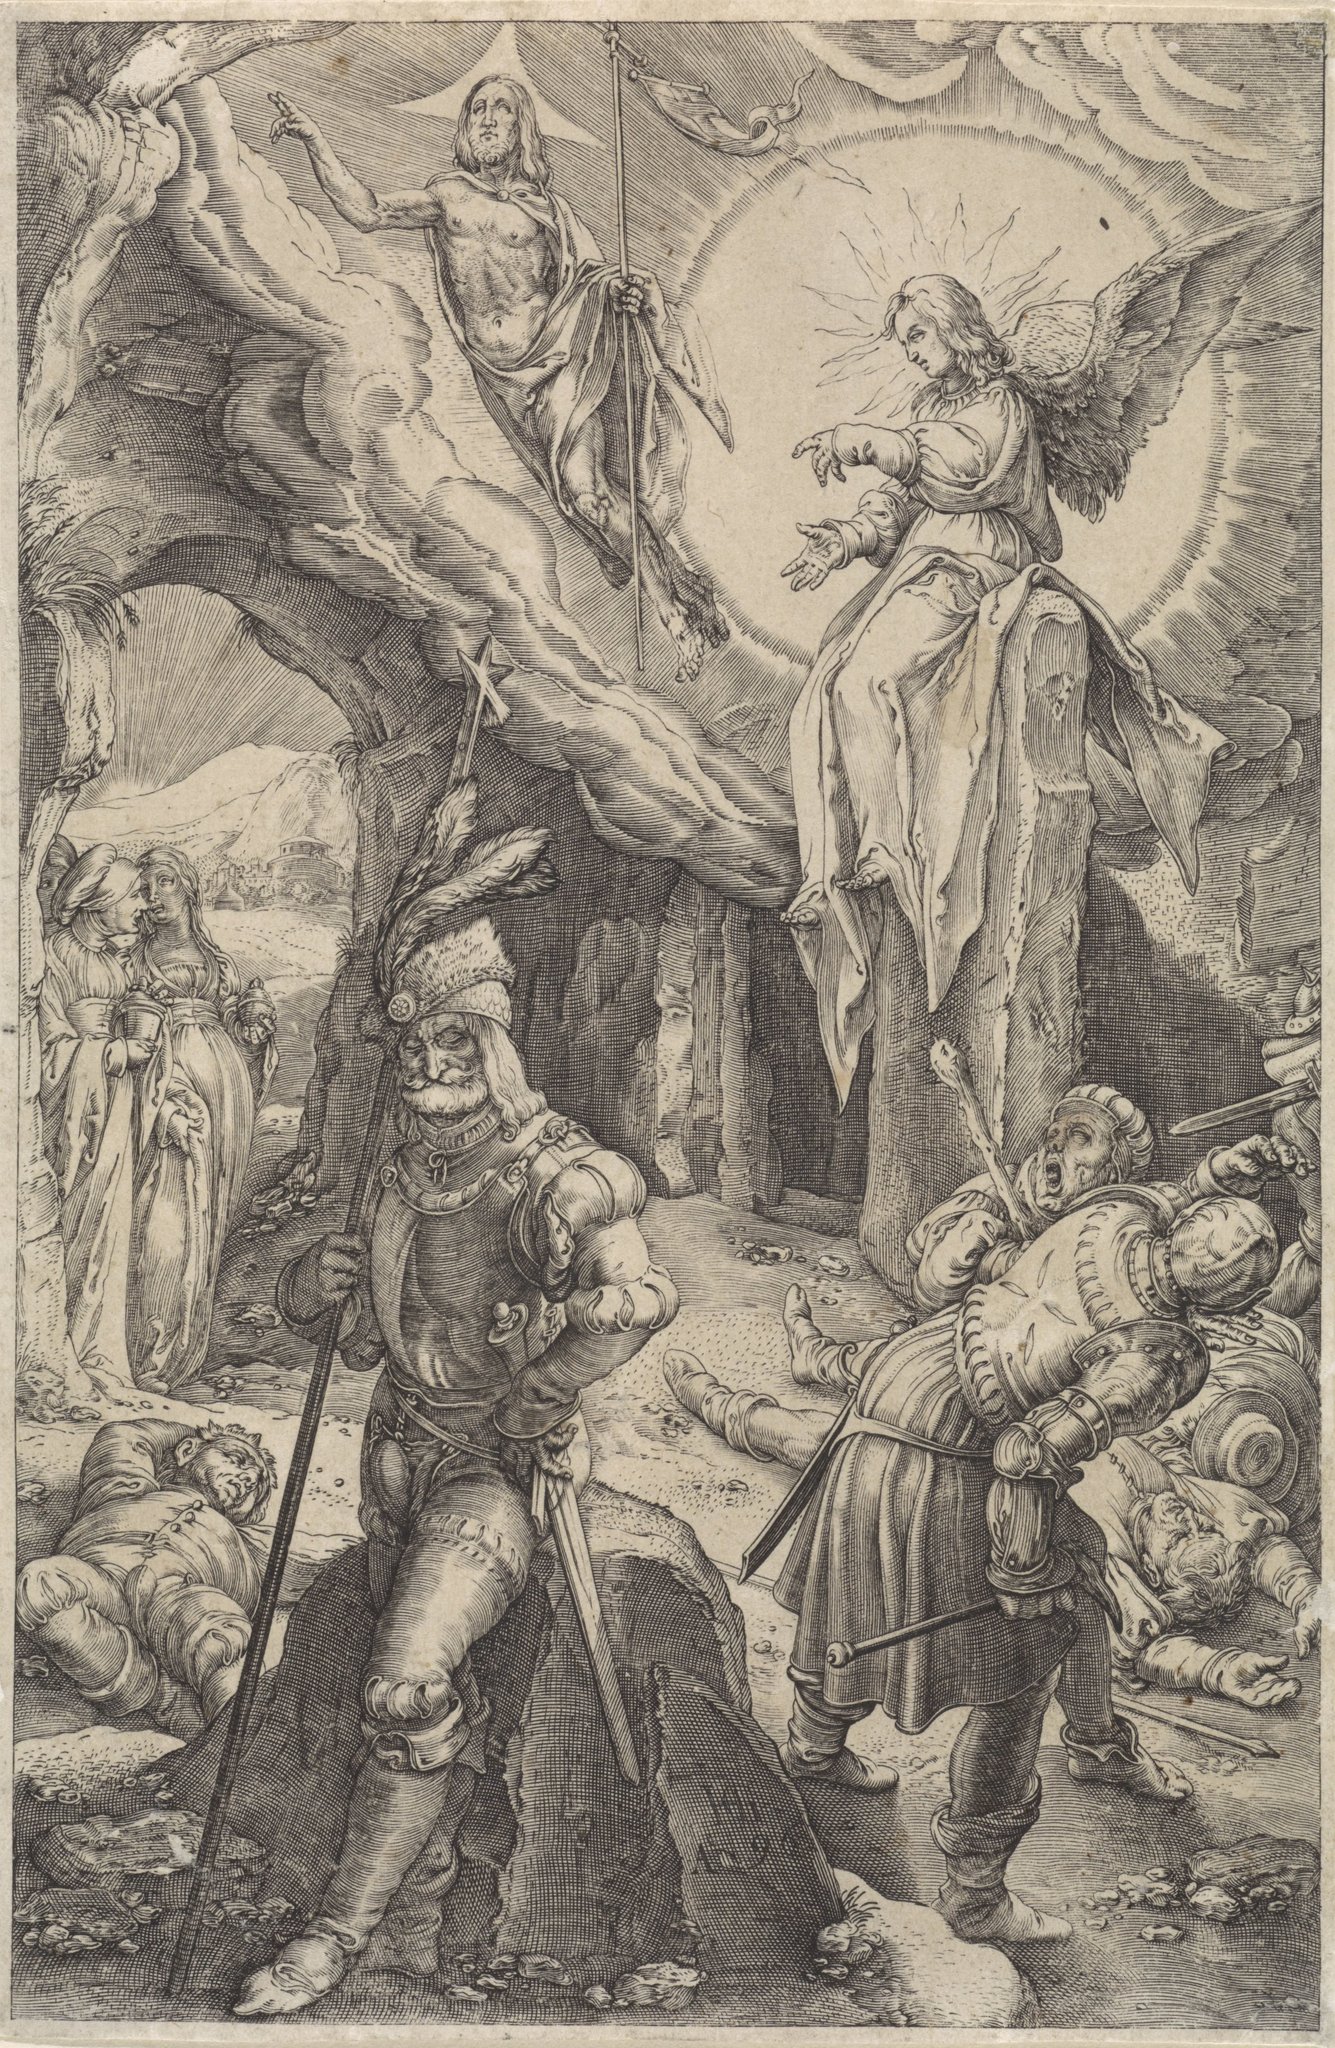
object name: print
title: Opstanding van Christus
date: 1596-1667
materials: paper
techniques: engraving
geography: netherlands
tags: angel(s) addressing the holy women ~ resurrection of christ, christ, usually holding a banner, arises from the grave; often combined with sleeping and/or frightened soldiers, christ floating above or near the tomb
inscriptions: collector's mark: Lugt 2228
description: Christus zweeft bij de ingang van zijn graf met een overwinningsbanier in de hand. De drie Maria's staan bij de ingang van het graf en zien een engel op de weggeschoven steen zitten. Enkele soldaten schrikken en een paar liggen te slapen op de grond.